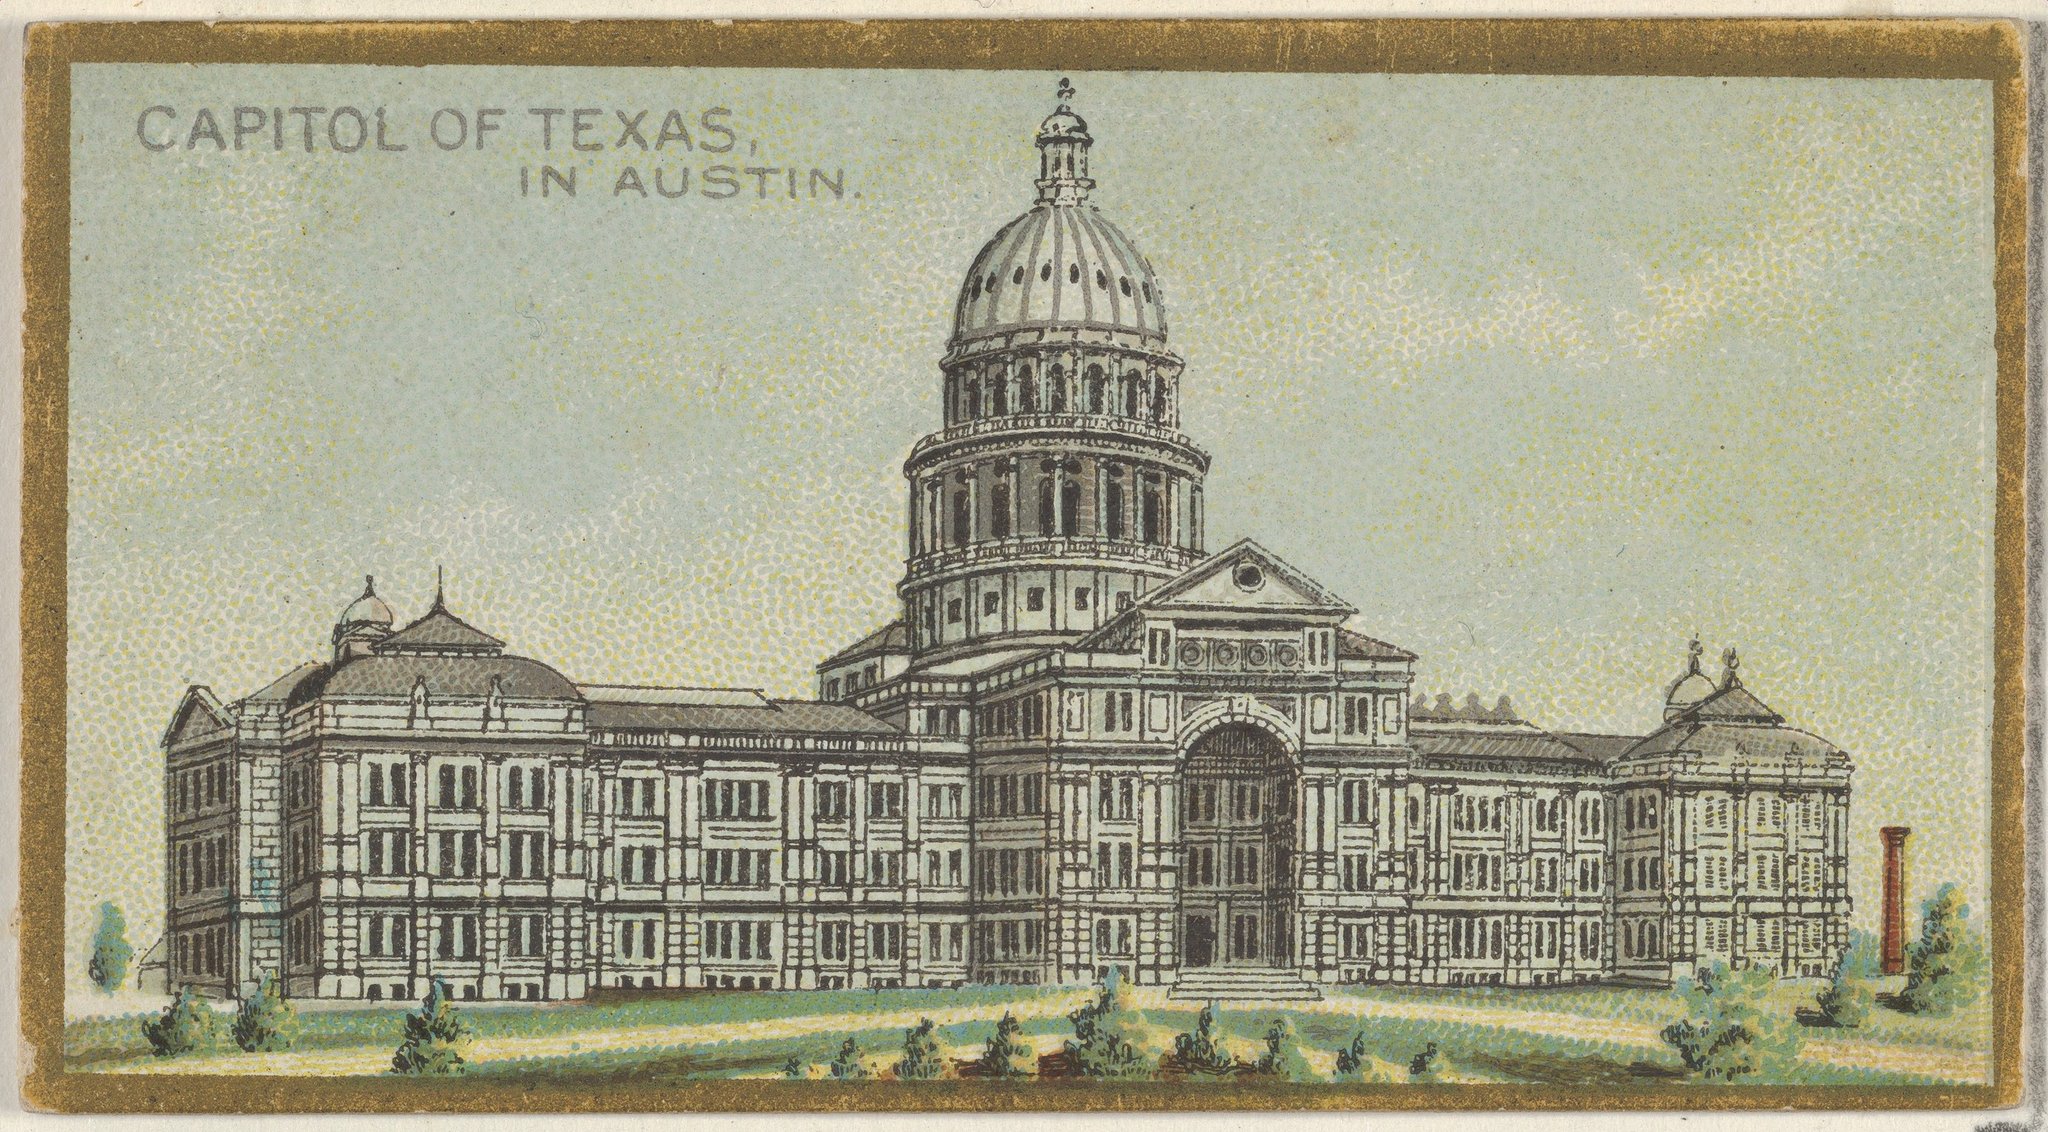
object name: print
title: Capitol of Texas in Austin, from the General Government and State Capitol Buildings series (N14) for Allen & Ginter Cigarettes Brands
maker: allen & ginter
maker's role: publisher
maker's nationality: american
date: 1889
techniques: color lithograph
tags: buildings